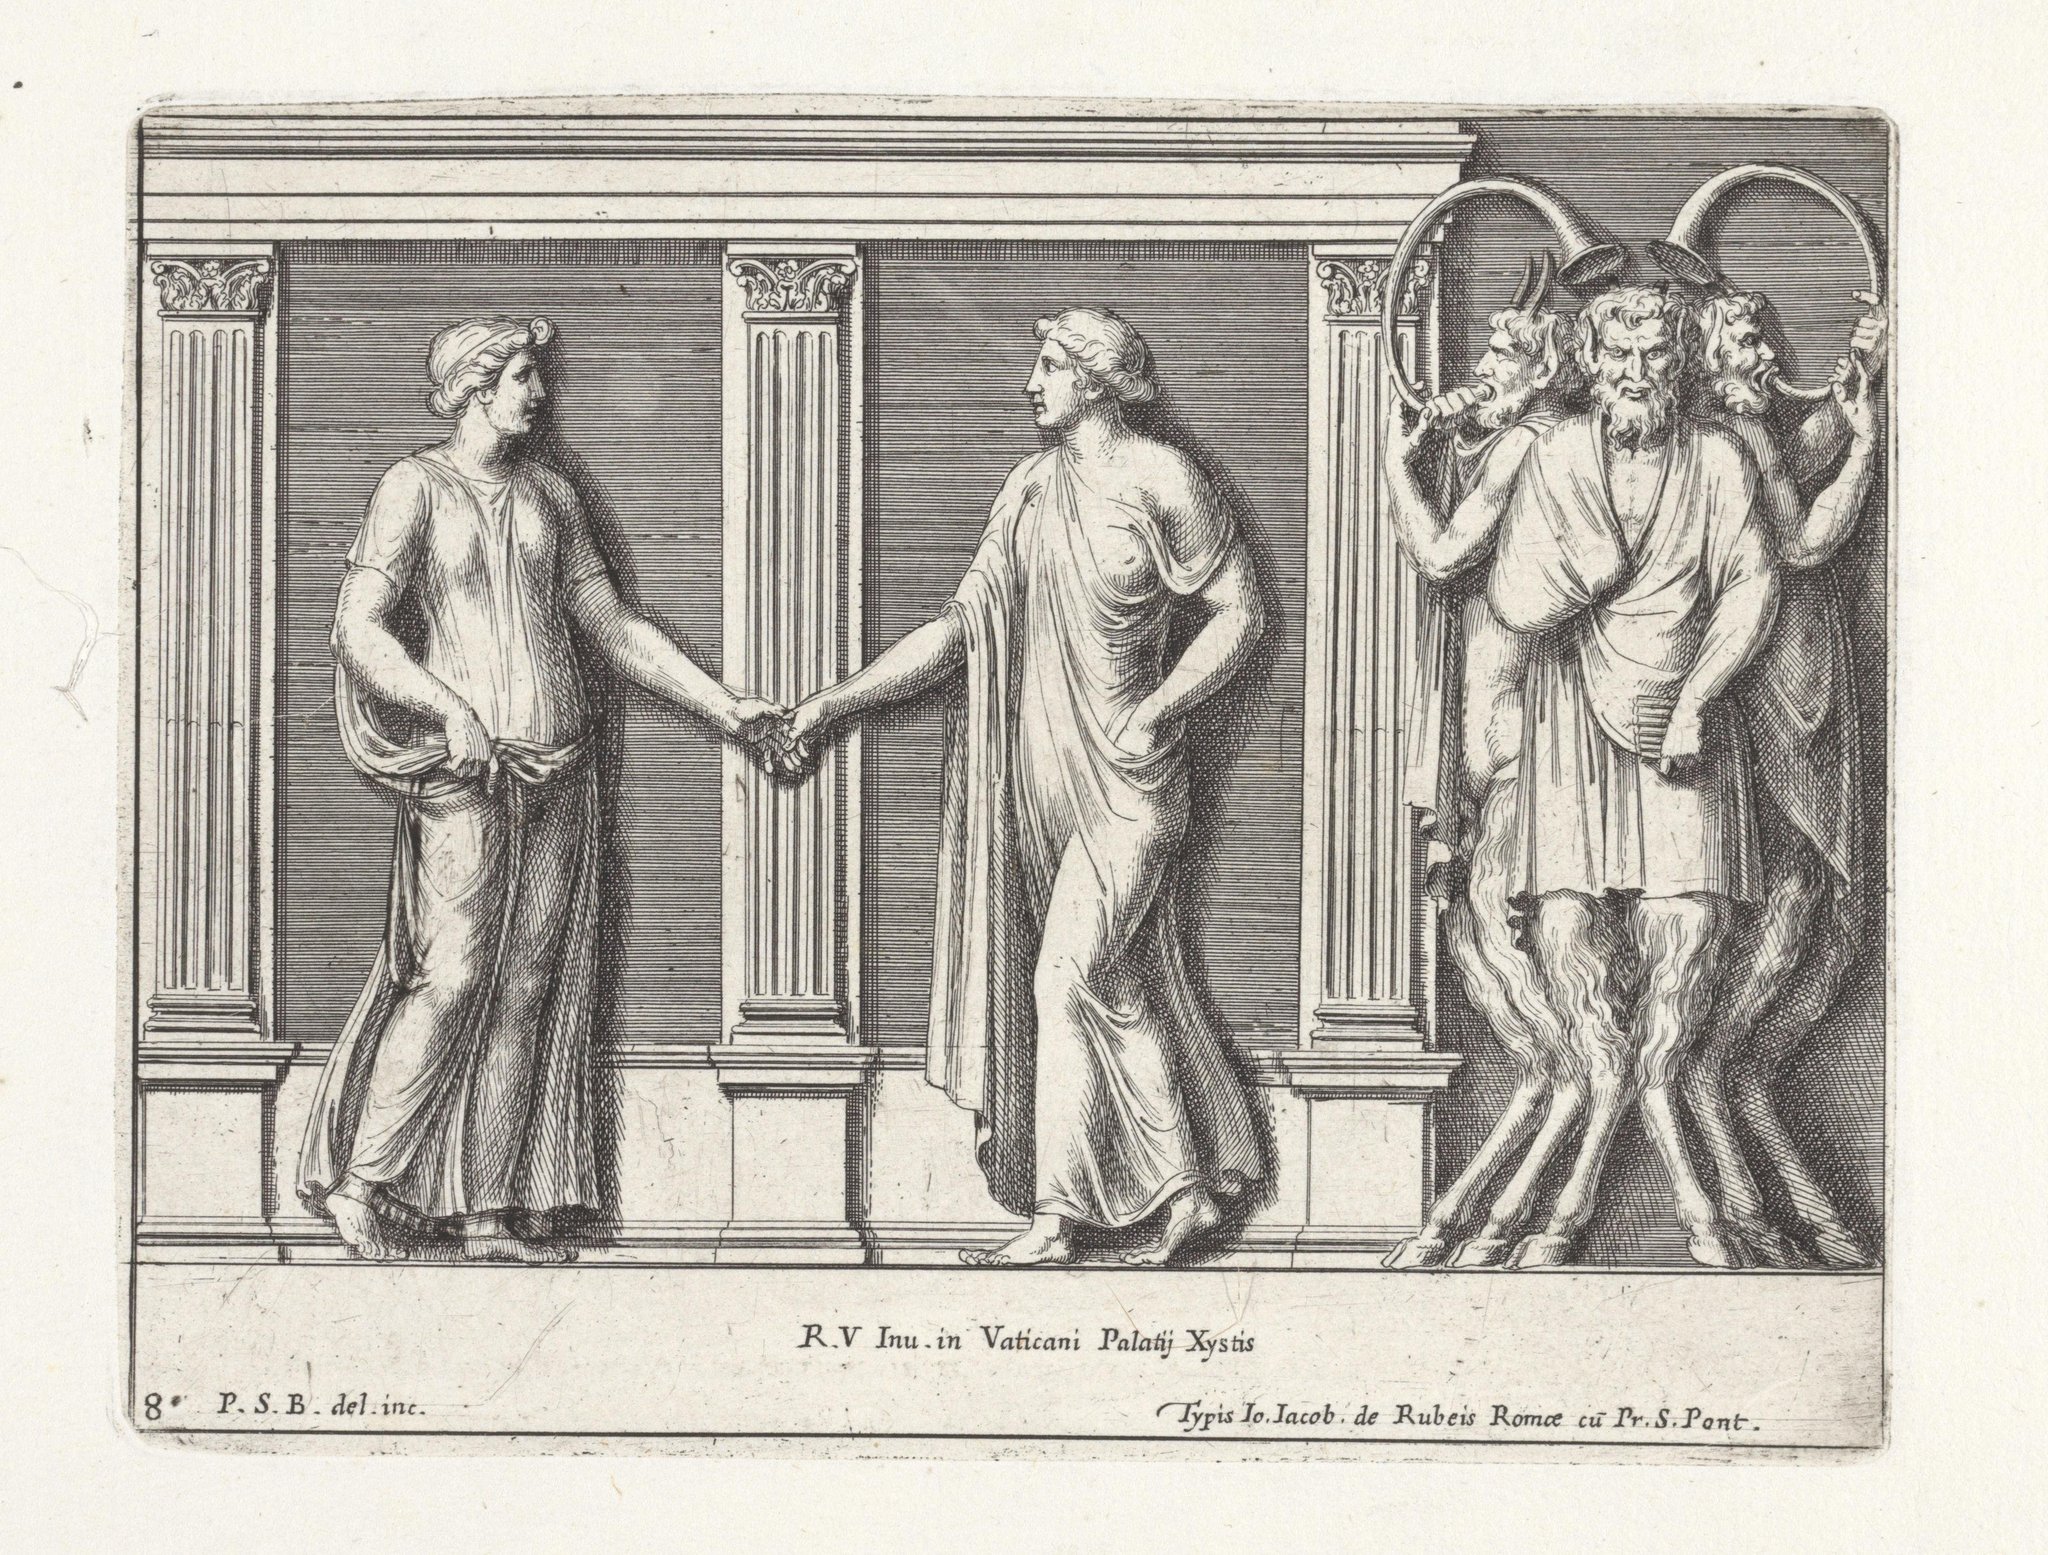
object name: print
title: Reliëfs in de Loggia van Rafaël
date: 1645-1700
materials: paper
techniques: engraving, etching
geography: vatican city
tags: adult woman, dancing, satyr(s) (in general)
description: Prent uit een reeks naar de gipsen reliëfs door Rafaël en uitgevoerd door zijn assistenten in de Vaticaanse Loggia.